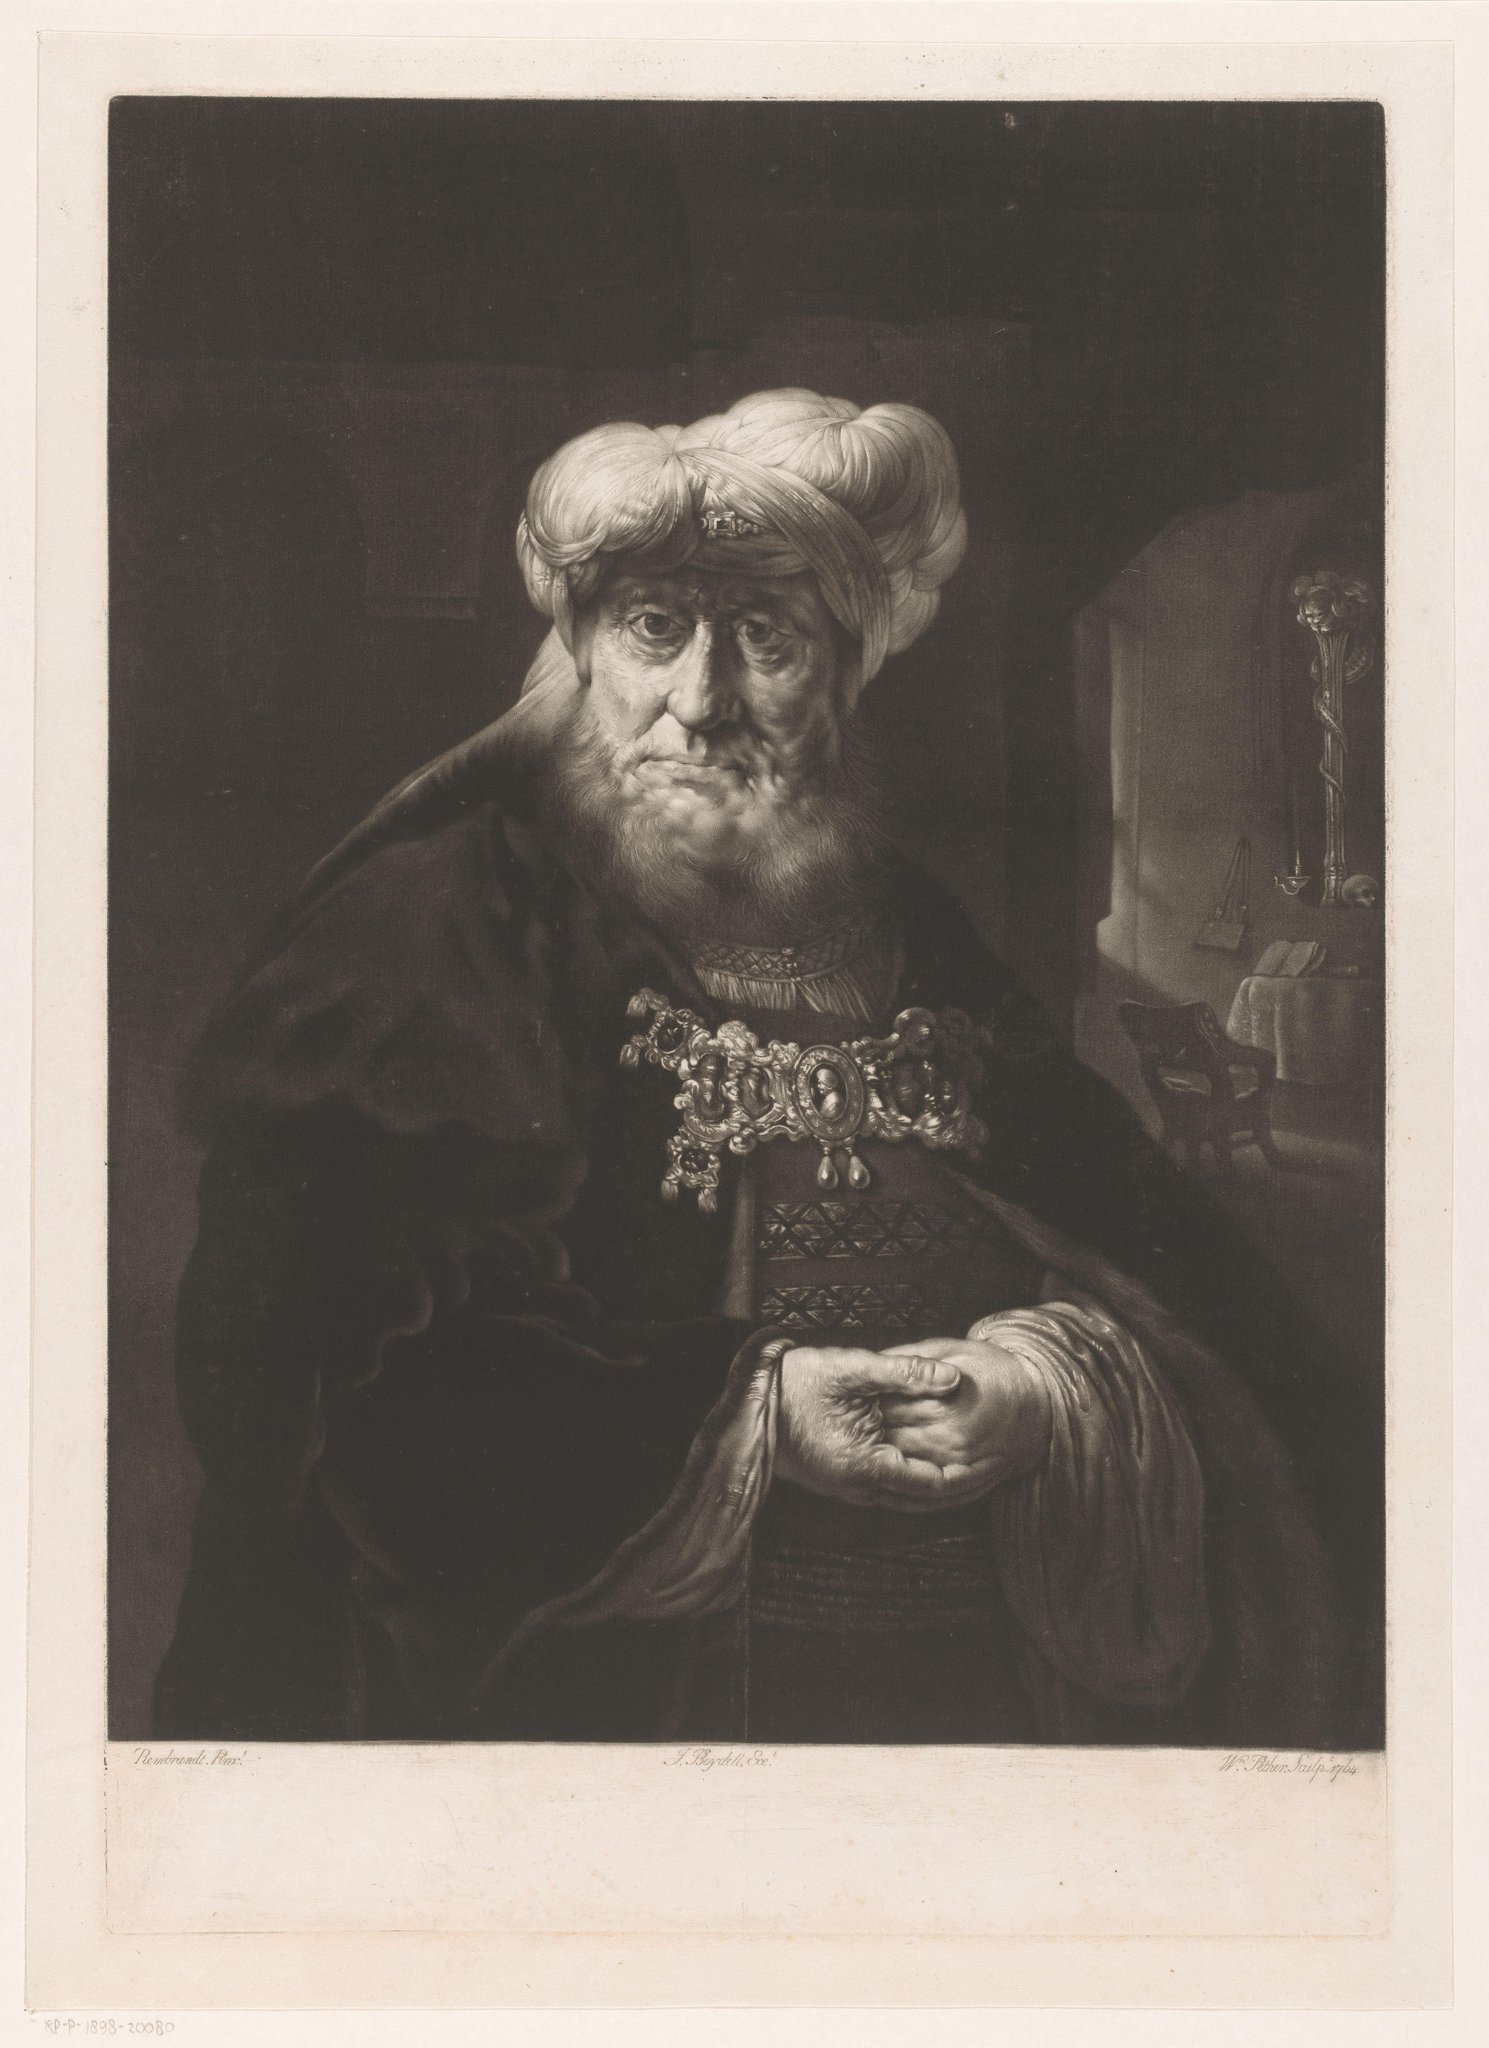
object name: print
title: A Jew Rabbi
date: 1764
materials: paper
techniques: mezzotint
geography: london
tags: story of uzziah (azariah), son of amaziah, king of judah (2 kings 15:1-7; 2 chronicles 26), chief rabbi, leprosy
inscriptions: collector's mark: Lugt 2228